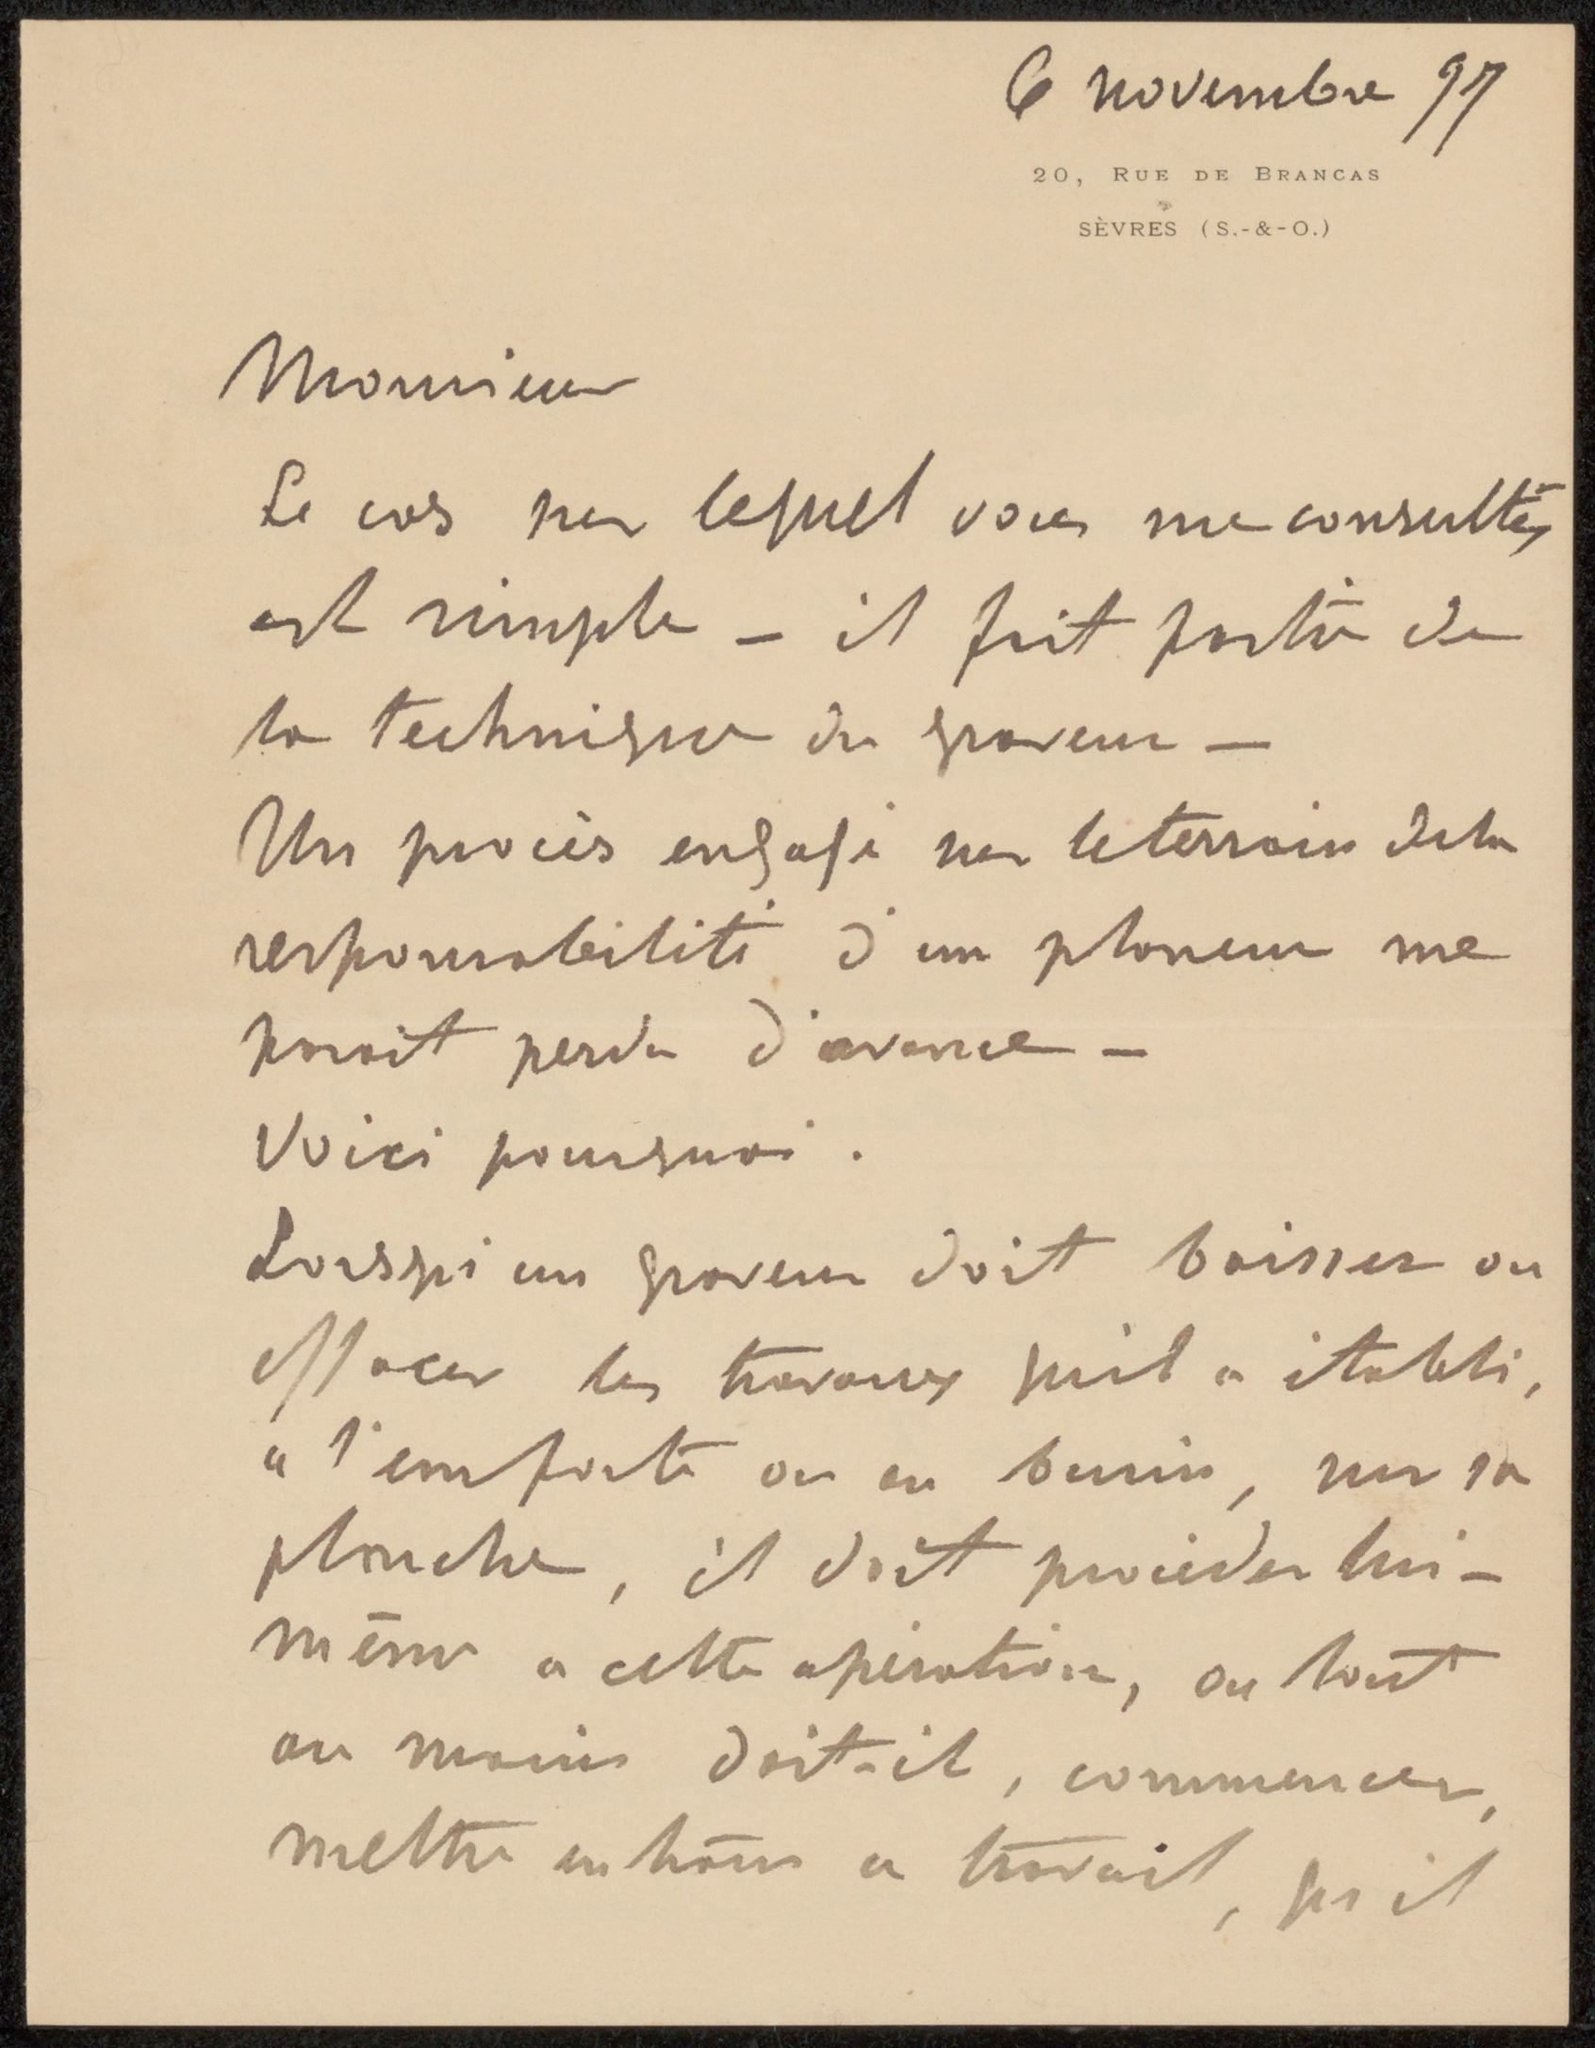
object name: letter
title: Brief aan Philip Zilcken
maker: félix bracquemond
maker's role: print maker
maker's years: 1833-1914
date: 1891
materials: ink, paper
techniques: pen, printing, writing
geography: sèvres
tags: the hague, painter, draughtsman, philip zilcken, etching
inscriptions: collector's mark: ‘RPK’